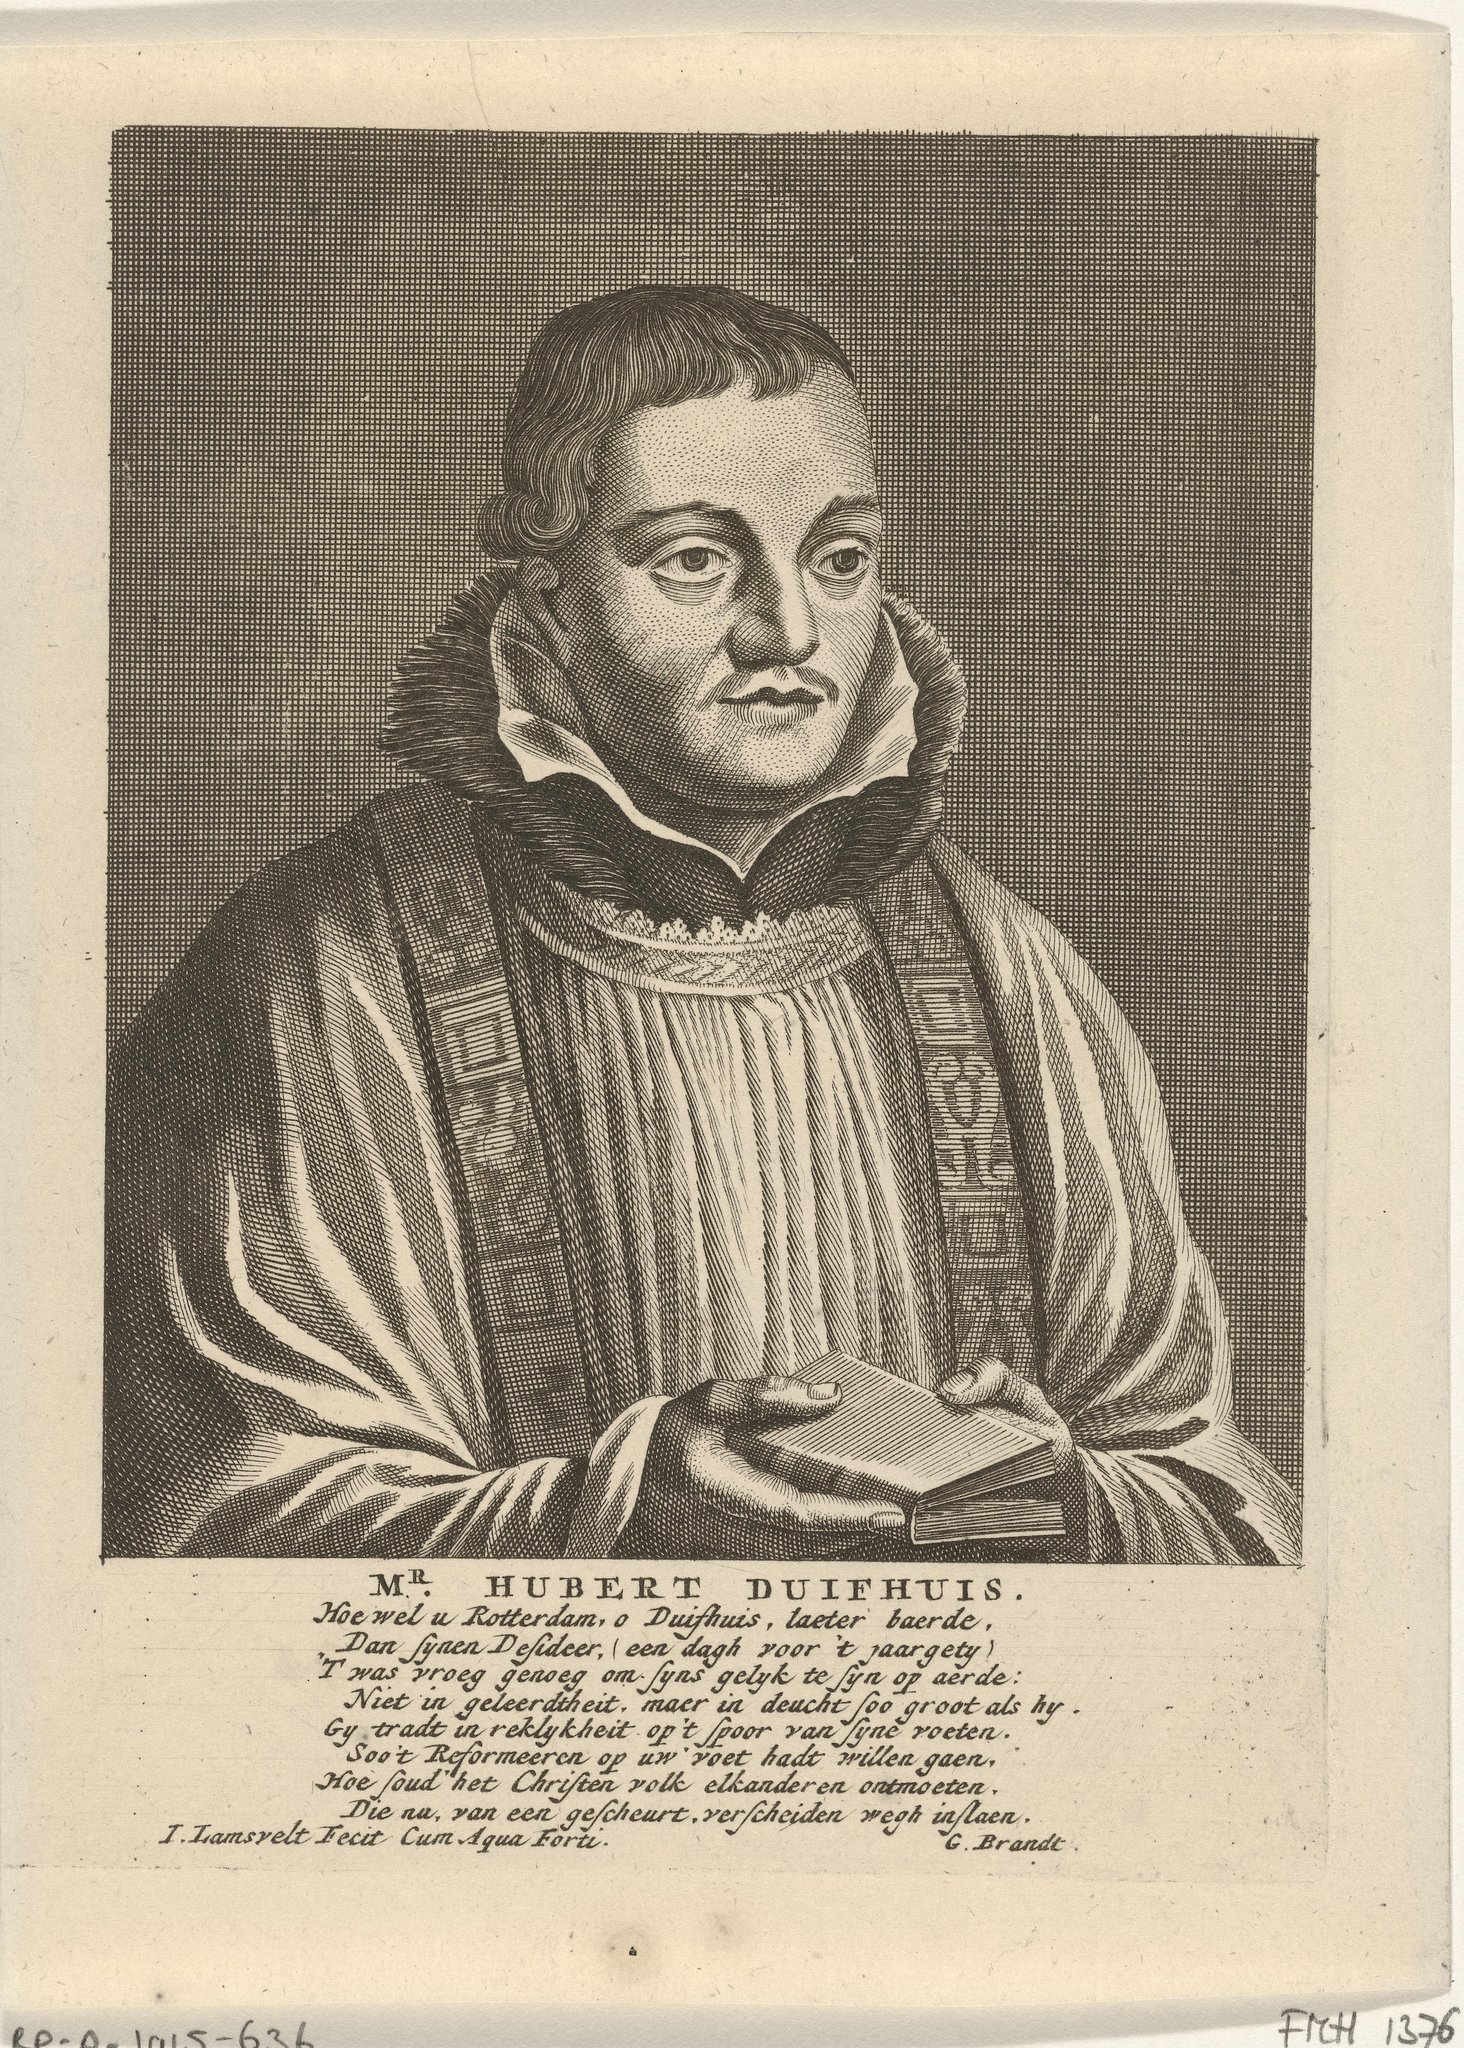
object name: print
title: Portret van Huibert Duifhuis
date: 1696-1743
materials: paper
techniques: engraving, etching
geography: amsterdam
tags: historical persons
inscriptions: collector's mark: Lugt 2228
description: Prent ook gebruikt in: G. Brandts Historie der Reformatie, en andre kerkelyke geschiedenissen, in en ontrent de Nederlanden. Met eenige aantekeningen en aenmerkingen, Naerder oversien, merkelijk vermeerdert, en vervolgt tot het jaer 1600 [Het eerste deel]. 2e druk [moet een latere druk zijn]. Amsterdam: Jan Rieuwertsz. I en Hendrik en Dirk Boom [?], 1677 [in of na 1696], tussen p. 612 en 613.* * Hoewel op de titelpagina deze uitgevers worden genoemd en het jaartal 1677 staat vermeld als jaar van uitgave, kan dit niet kloppen. Deze uitgave heeft weliswaar tevens exact dezelfde titel als de werkelijke tweede druk uit 1677, maar is typografisch anders en bevat andere prenten. Alle prenten zijn van de hand van Jan Lamsvelt (werkzame periode: 1696-1743), waardoor het geheel in of na 1696 te dateren valt.